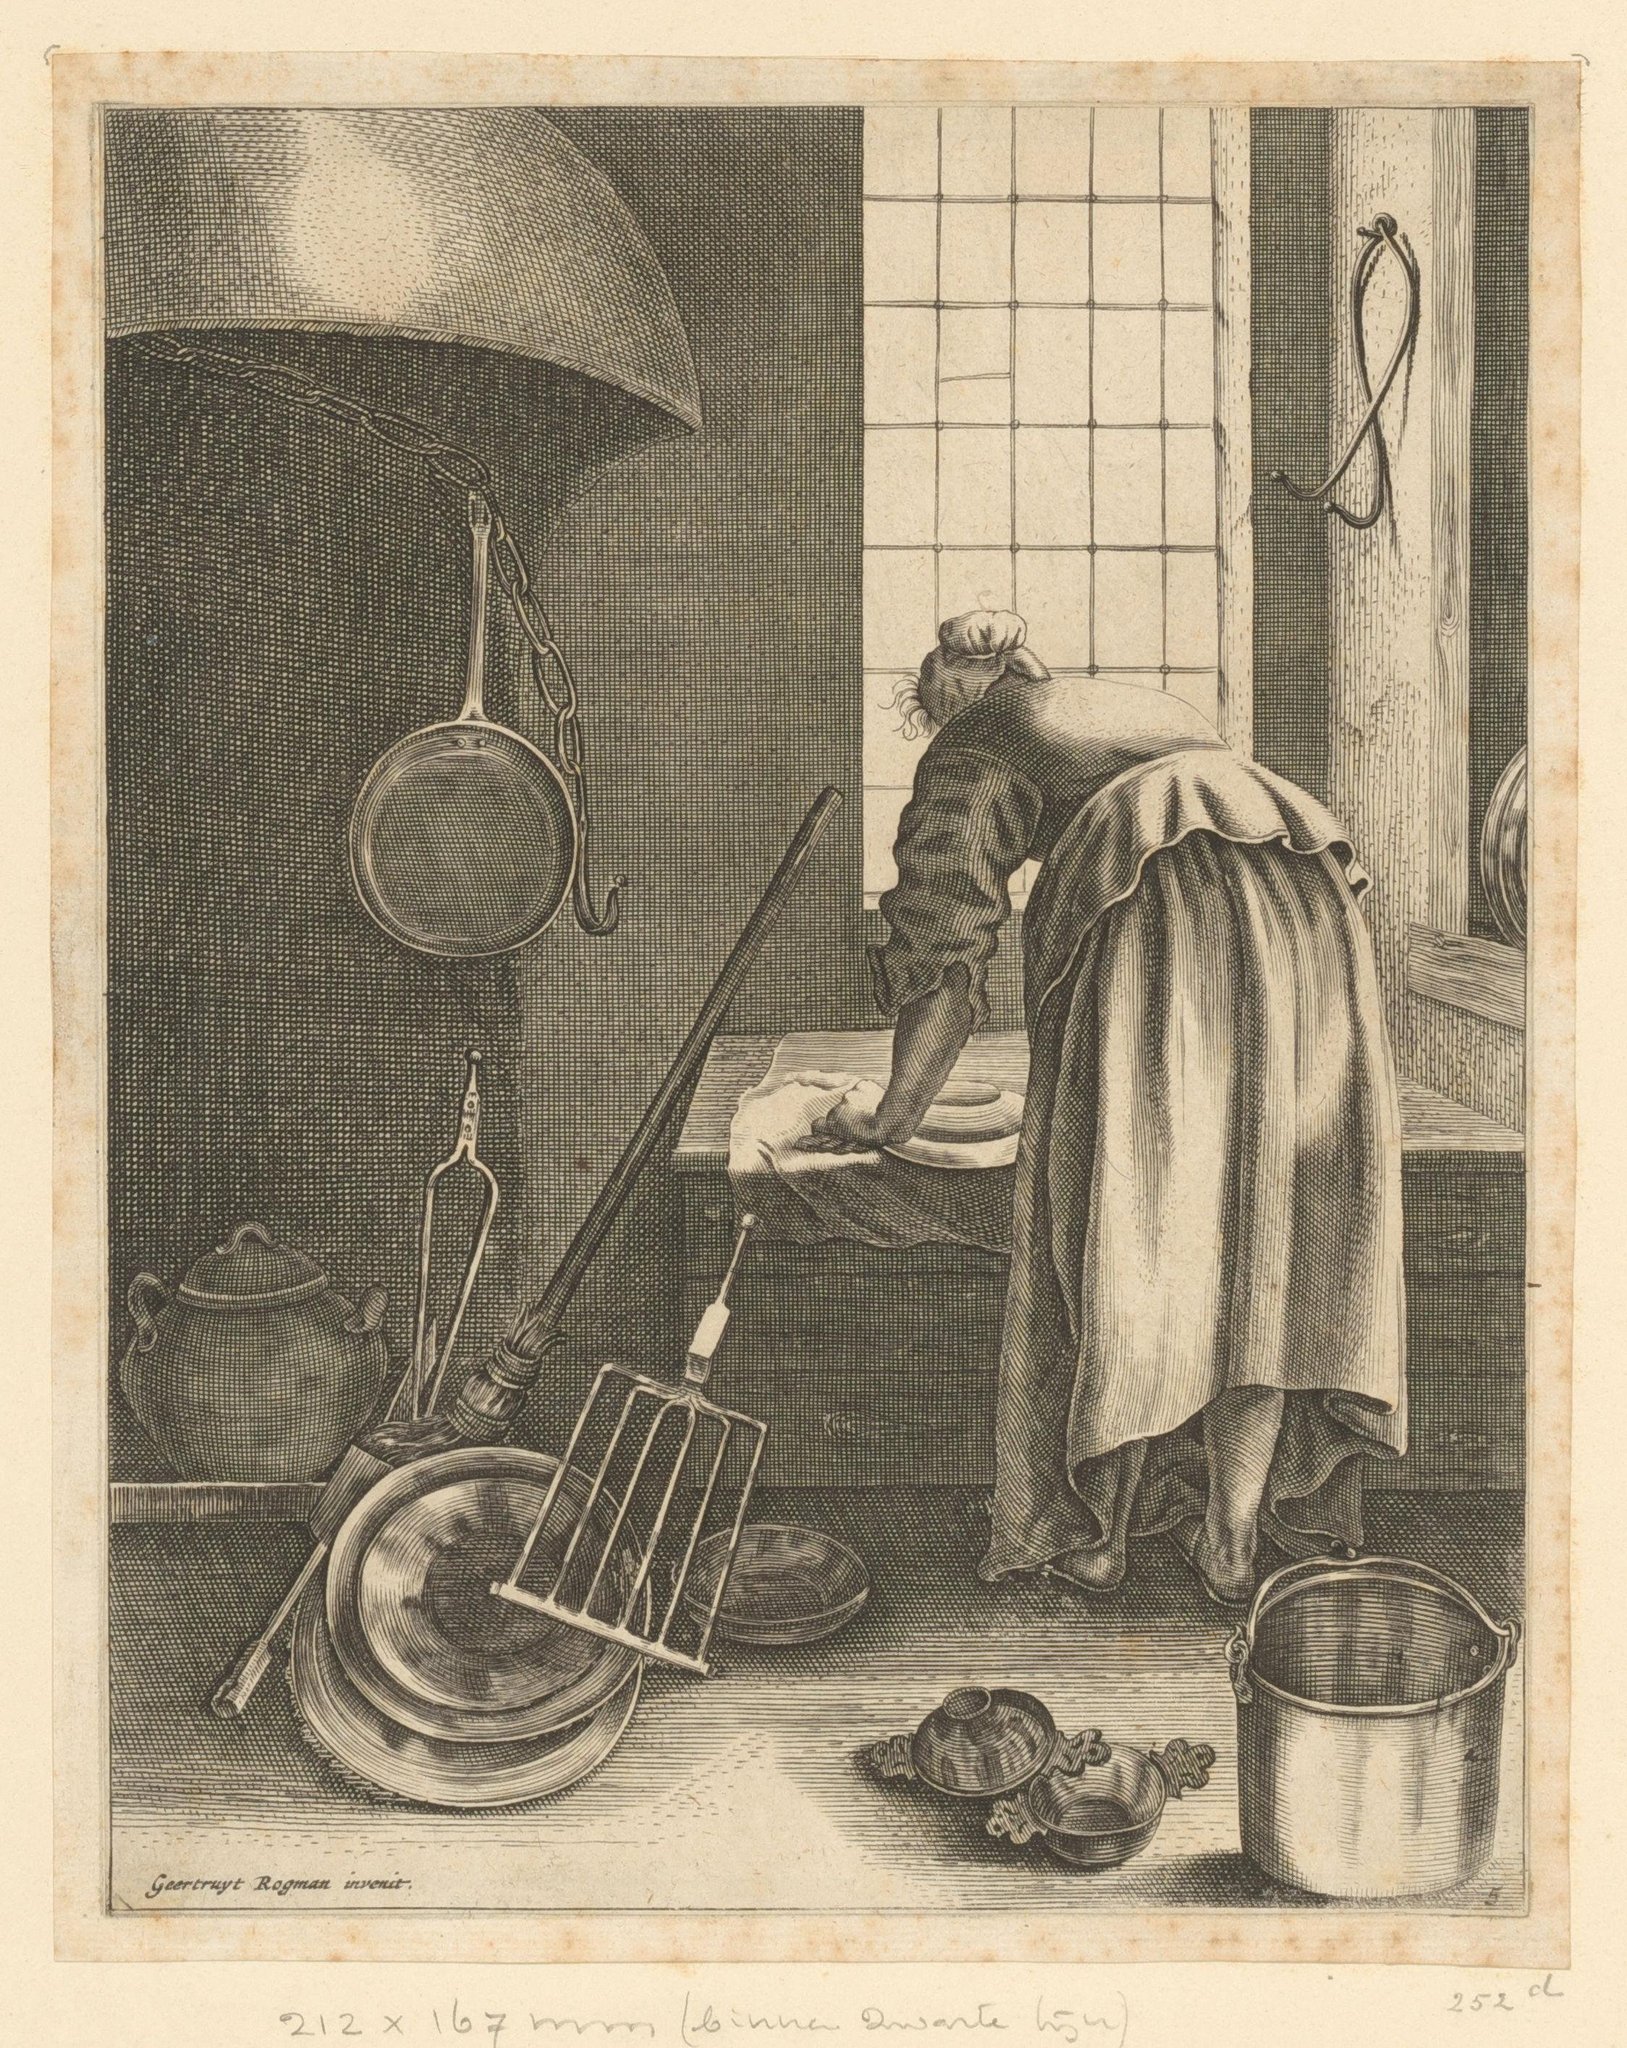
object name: print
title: Huiselijke werkzaamheden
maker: geertruydt roghman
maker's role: print maker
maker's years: 1625-1657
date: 1648-1650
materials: paper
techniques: engraving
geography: netherlands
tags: polishing (~ cleaning the house), kitchen-utensils, kitchen, cleaning (the house), maid ~ house personnel, kitchen-maid, kitchen servant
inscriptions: collector's mark, collector's mark: Lugt 1641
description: Een vrouw, op de rug gezien, bezig met het poetsen van een koperen schotel. Om haar heen diverse reeds gepoetste voorwerpen, zoals een emmer, een hangijzer, een rooster, een tang, schotels, enz. Rechtsonder genummerd: 5. De prent maakt deel uit van een serie van vijf prenten met huiselijke werkzaamheden. Onderwerpsrubrieken binnen de Atlas Zeden en Gewoonten: Beroep en bedrijf. Vrouwelijk beroep en bedrijf. Dienstboden.